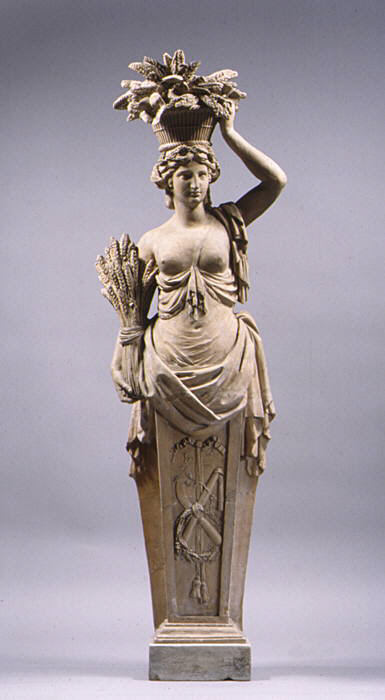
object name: canephore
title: Summer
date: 1775-1785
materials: terracotta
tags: women,female nudes